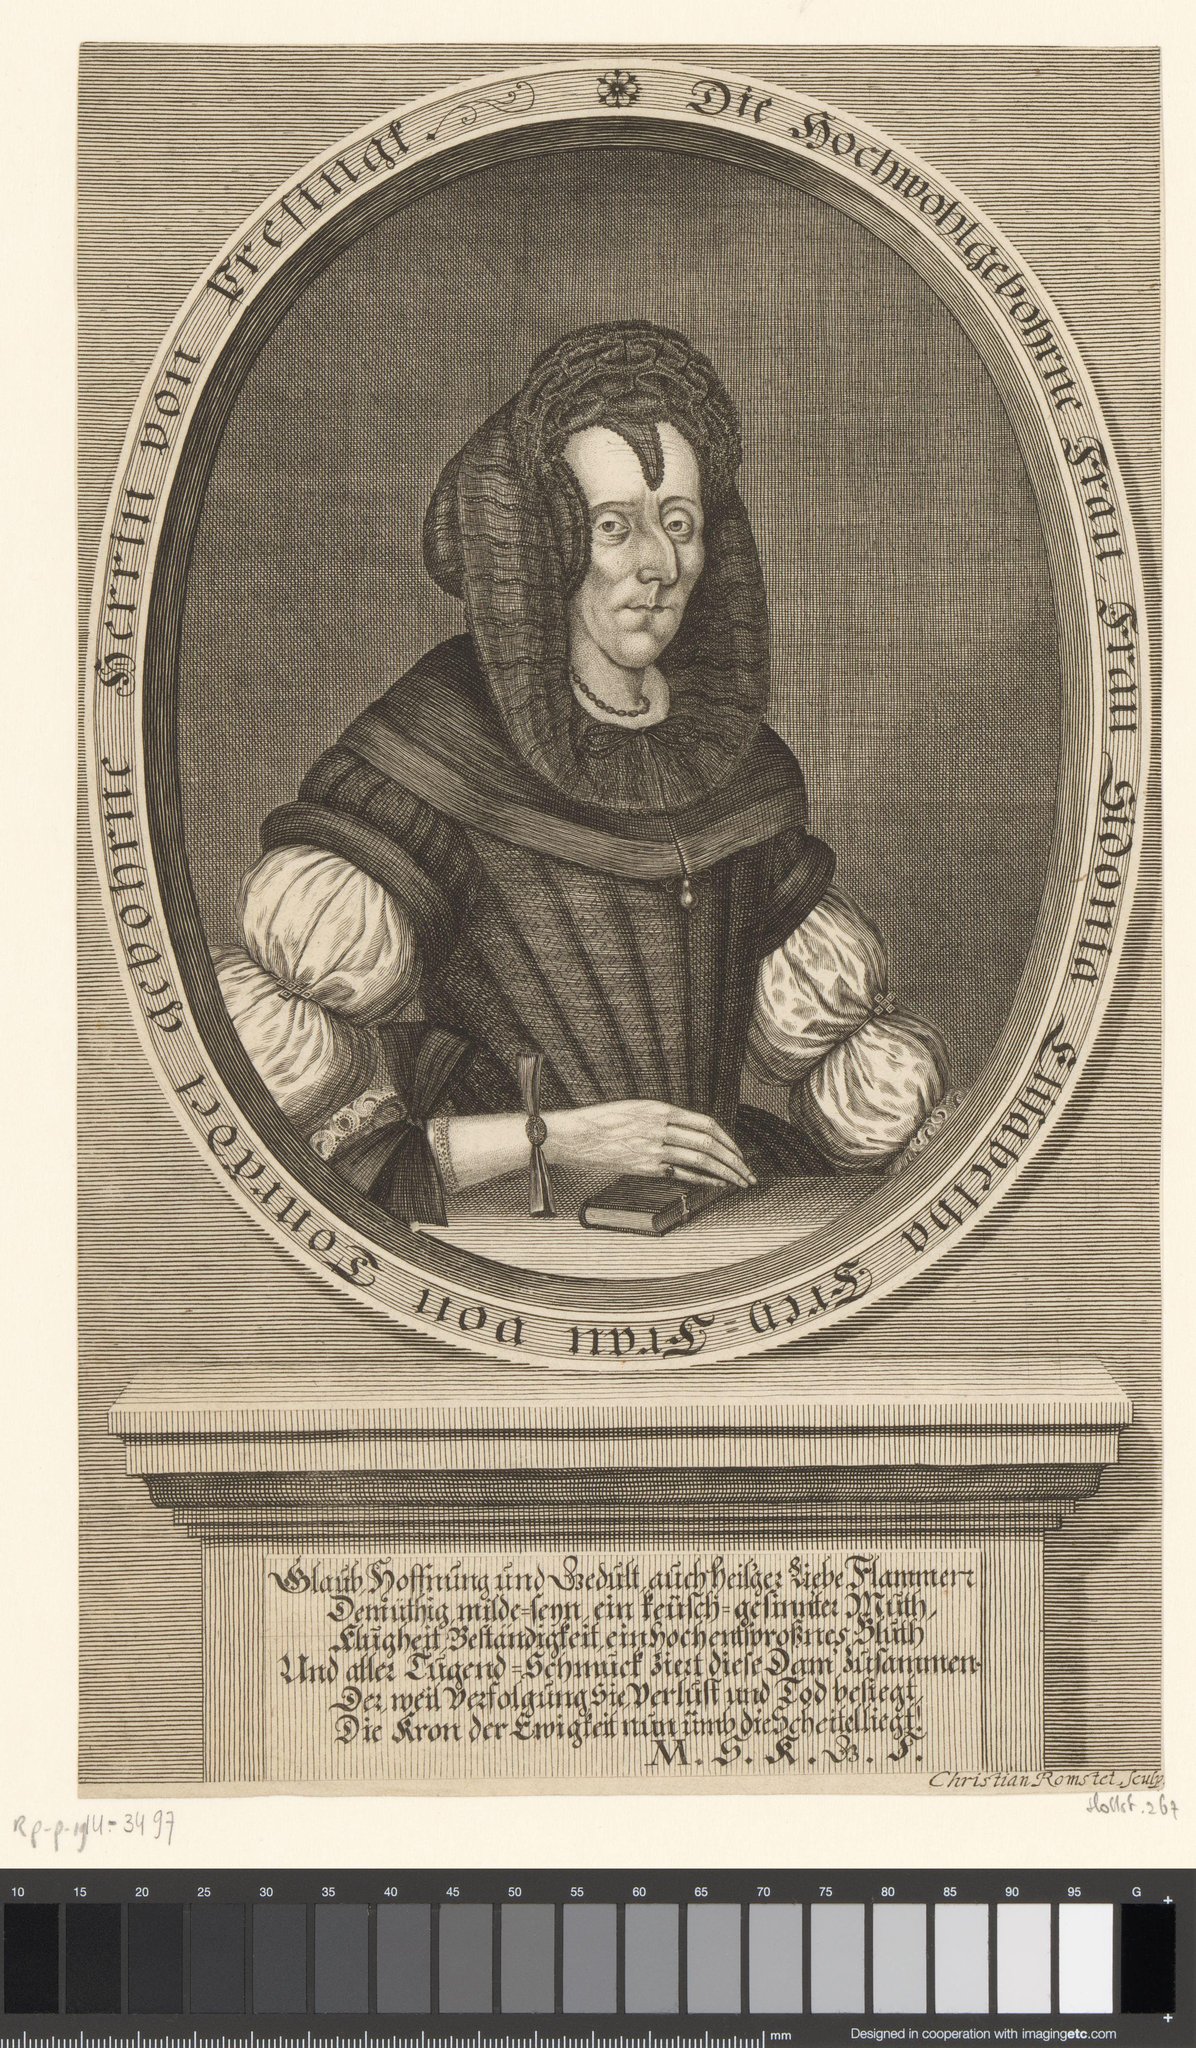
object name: print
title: Portret van Sidonia Elisabeth Tonrädel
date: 1665-1721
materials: paper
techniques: engraving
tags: historical persons - bb - woman, book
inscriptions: collector's mark: Lugt 2228